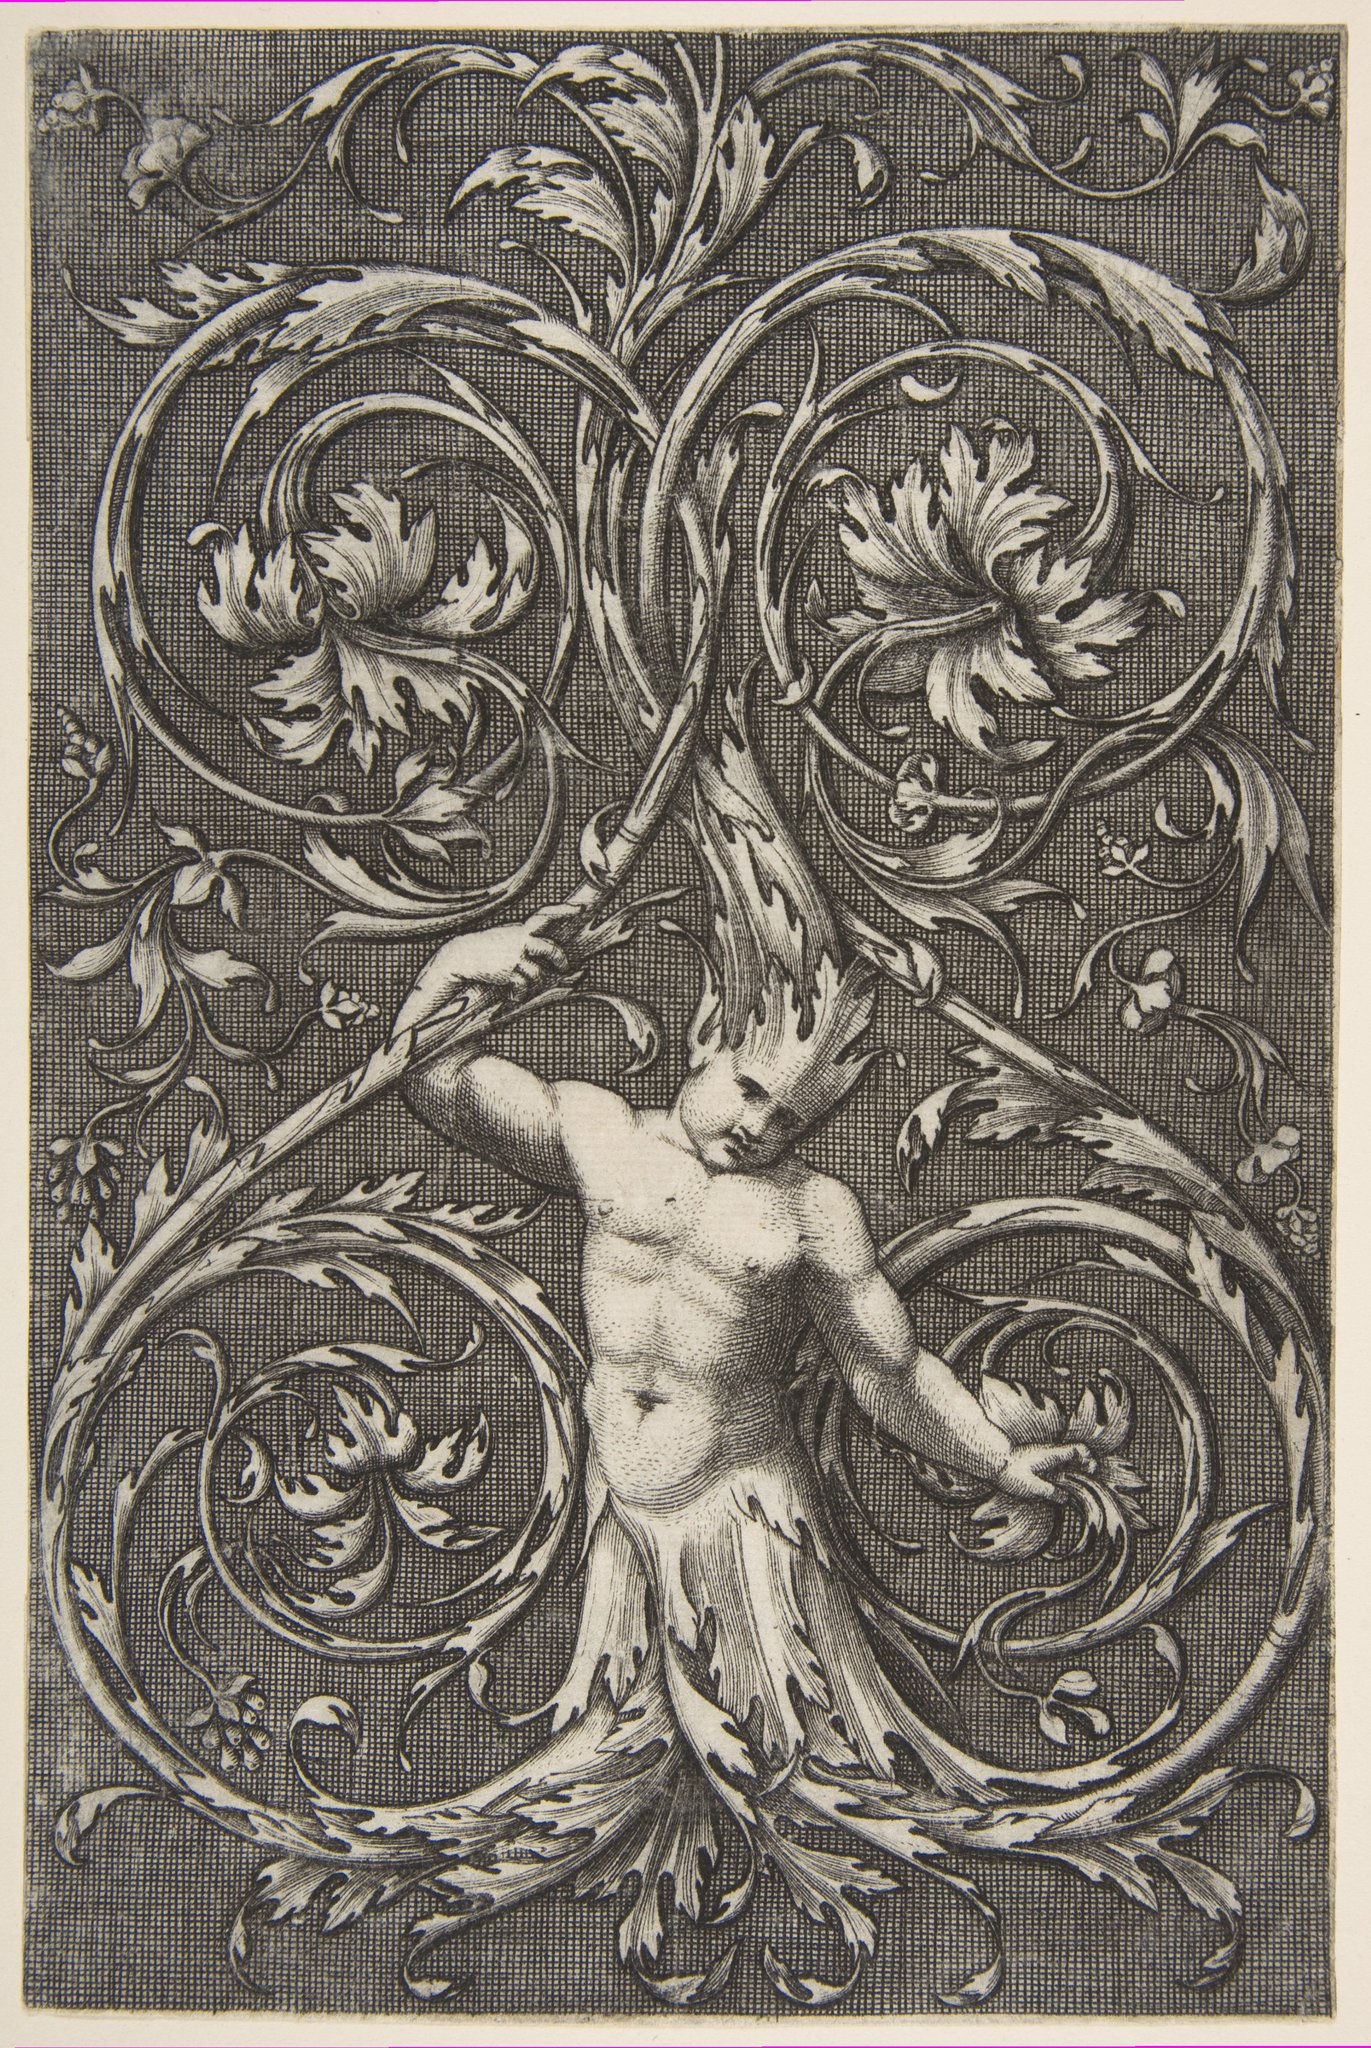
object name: print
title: Grotesque with male figure with lower body and head of acanthus scrolls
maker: anonymous, italian, 16th to early 17th century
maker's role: artist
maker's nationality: italian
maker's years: 1500-1640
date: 1515-1600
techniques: engraving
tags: grotesques,ornament,men,acanthus